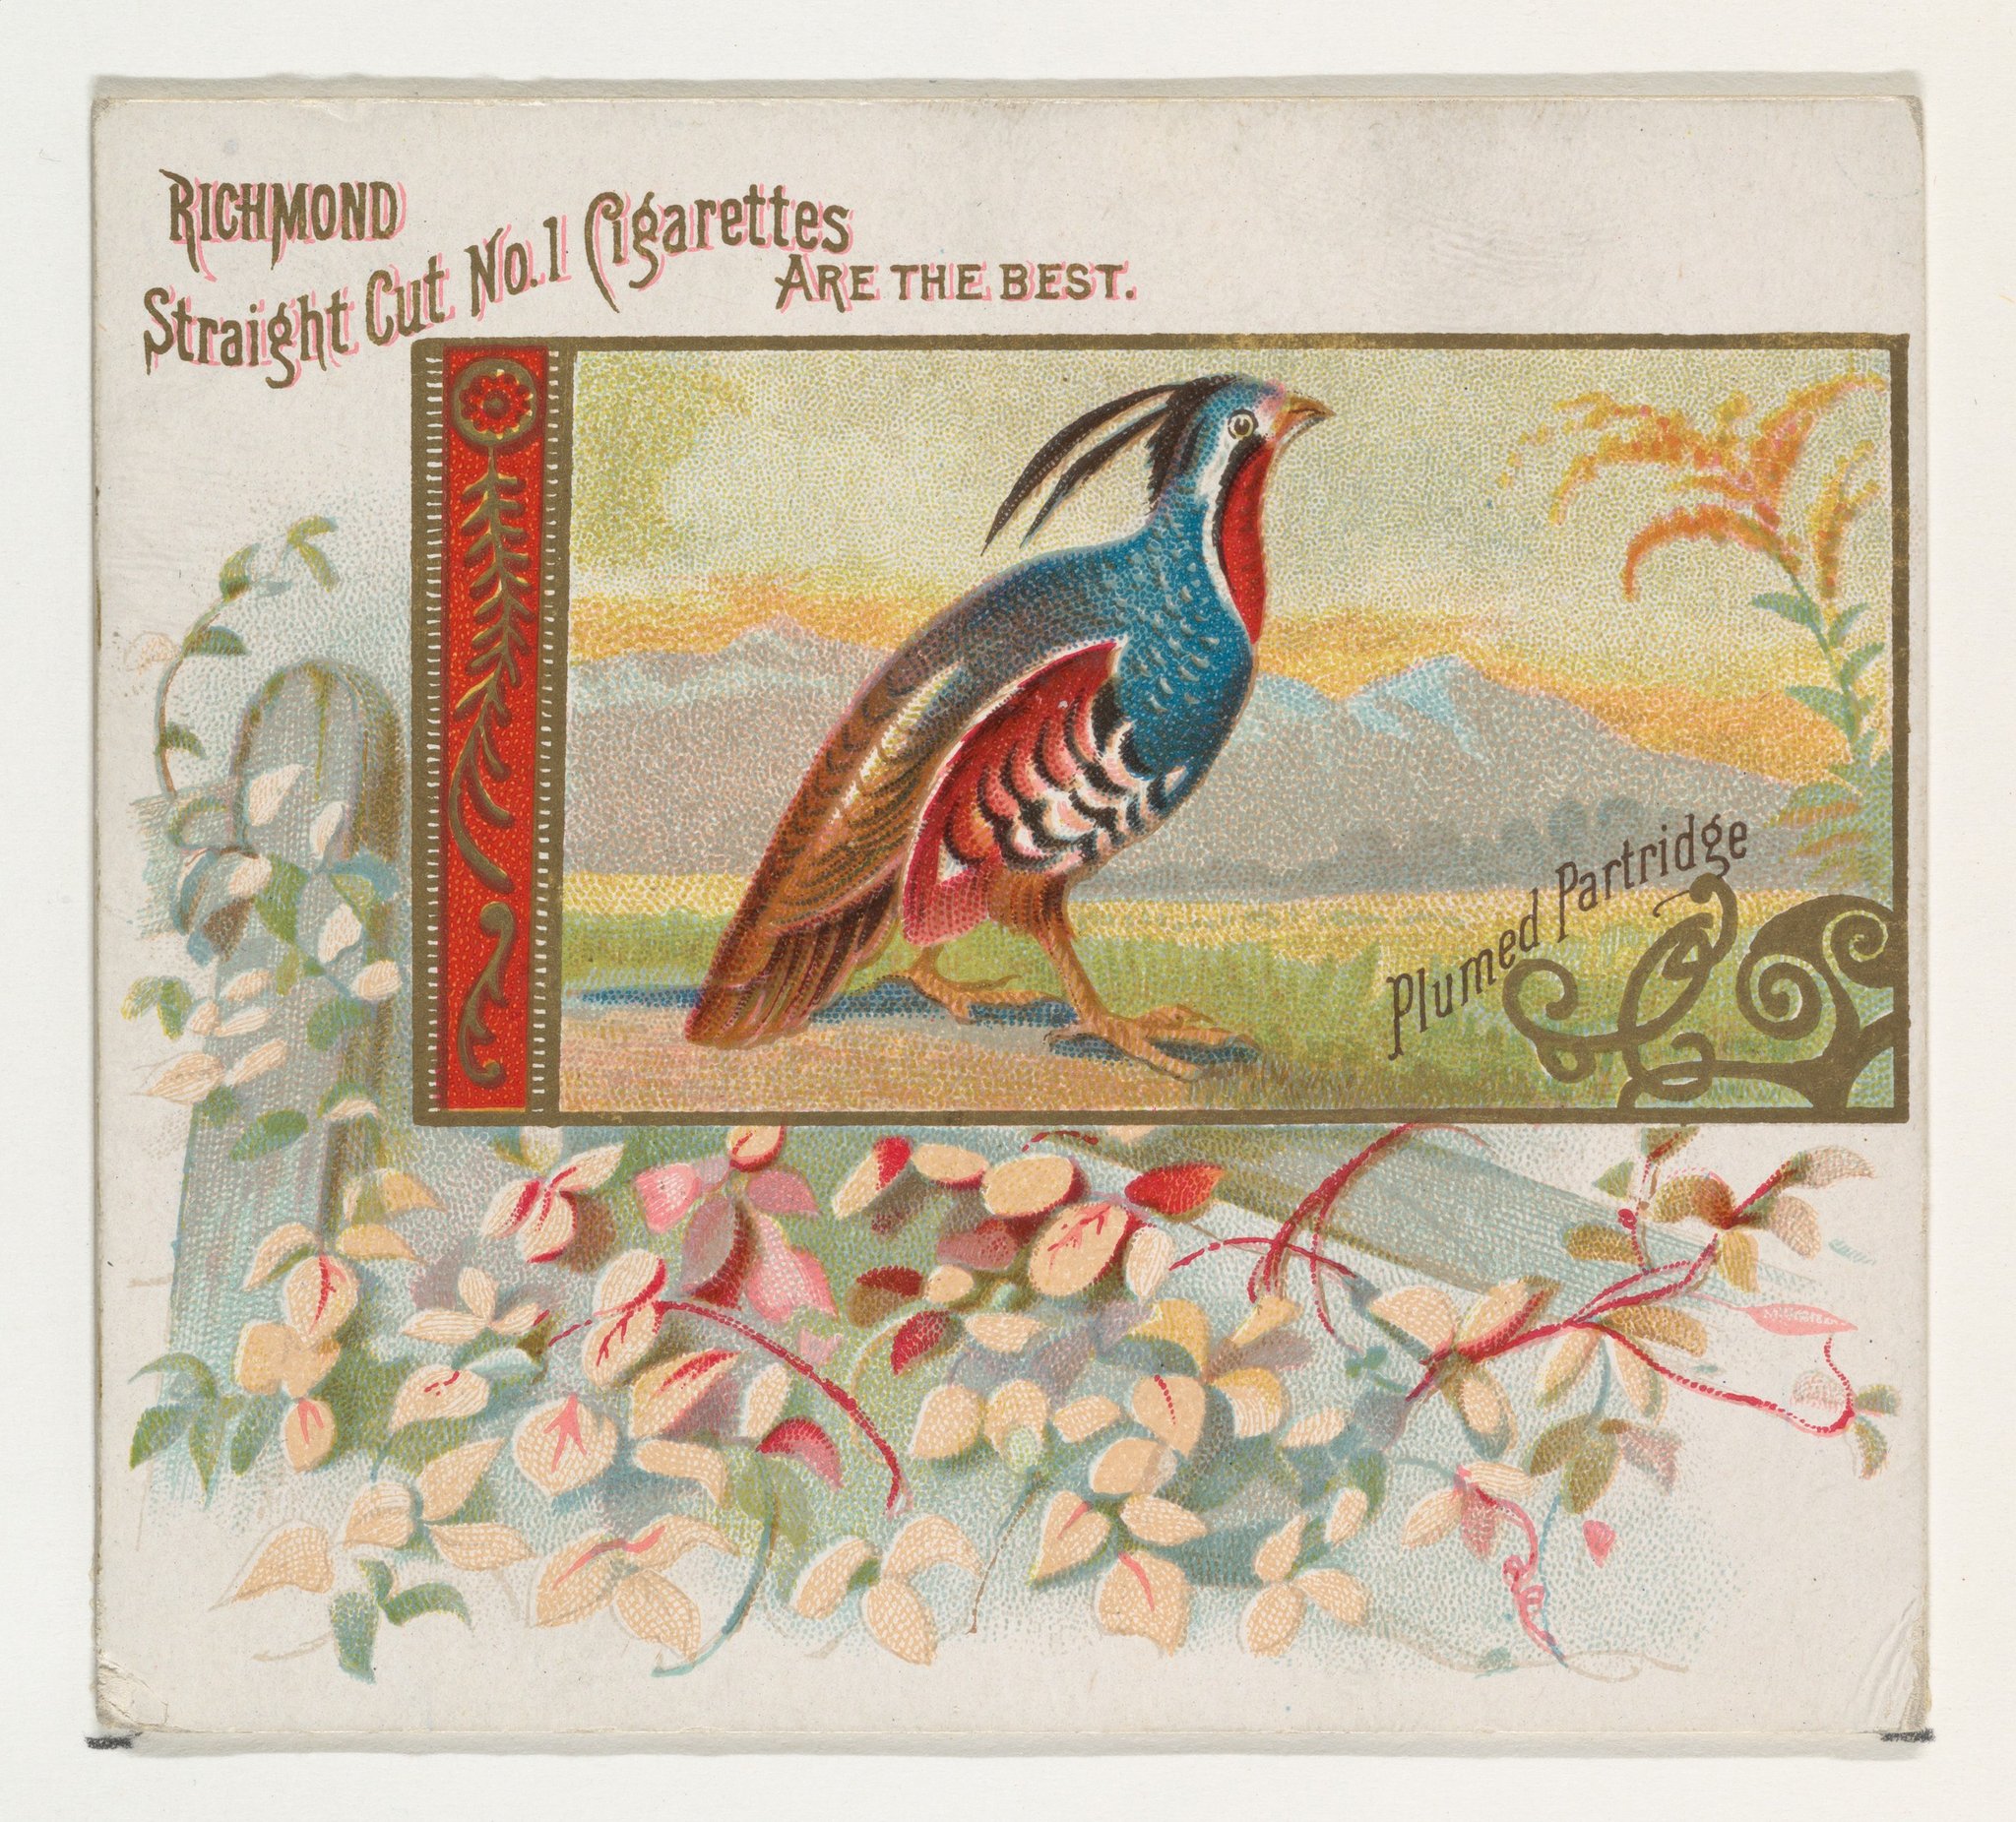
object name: print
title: Plumed Partridge, from the Game Birds series (N40) for Allen & Ginter Cigarettes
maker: allen & ginter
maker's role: publisher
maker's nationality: american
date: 1888-1890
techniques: color lithograph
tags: birds